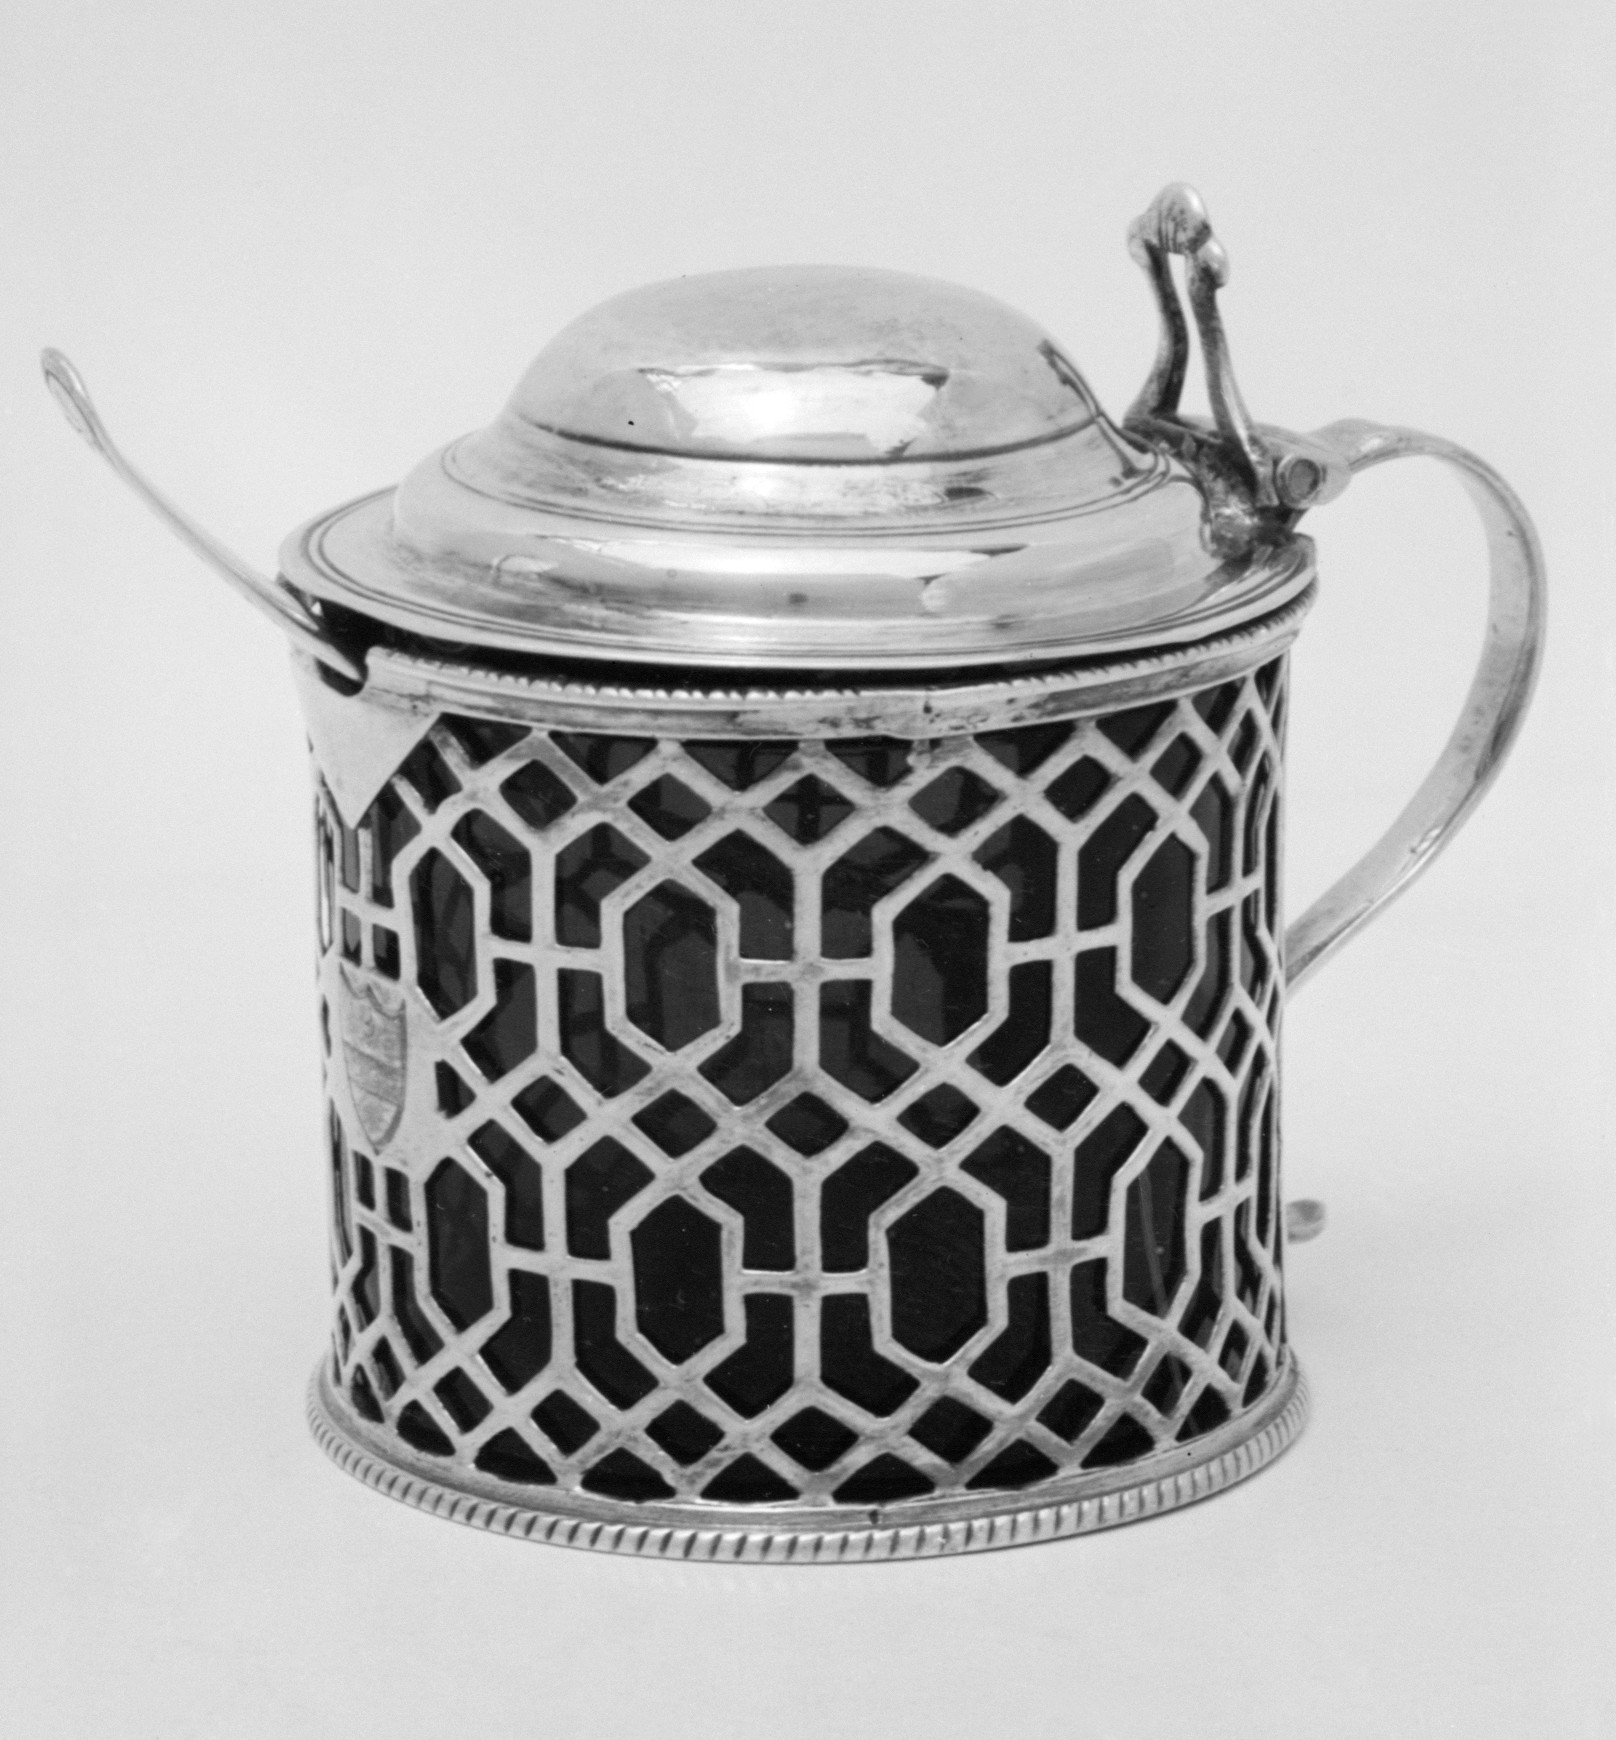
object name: mustard spoon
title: Mustard pot and spoon (one of a pair)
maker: edward aldridge ii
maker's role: maker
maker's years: 1758-1781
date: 1771-1772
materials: silver